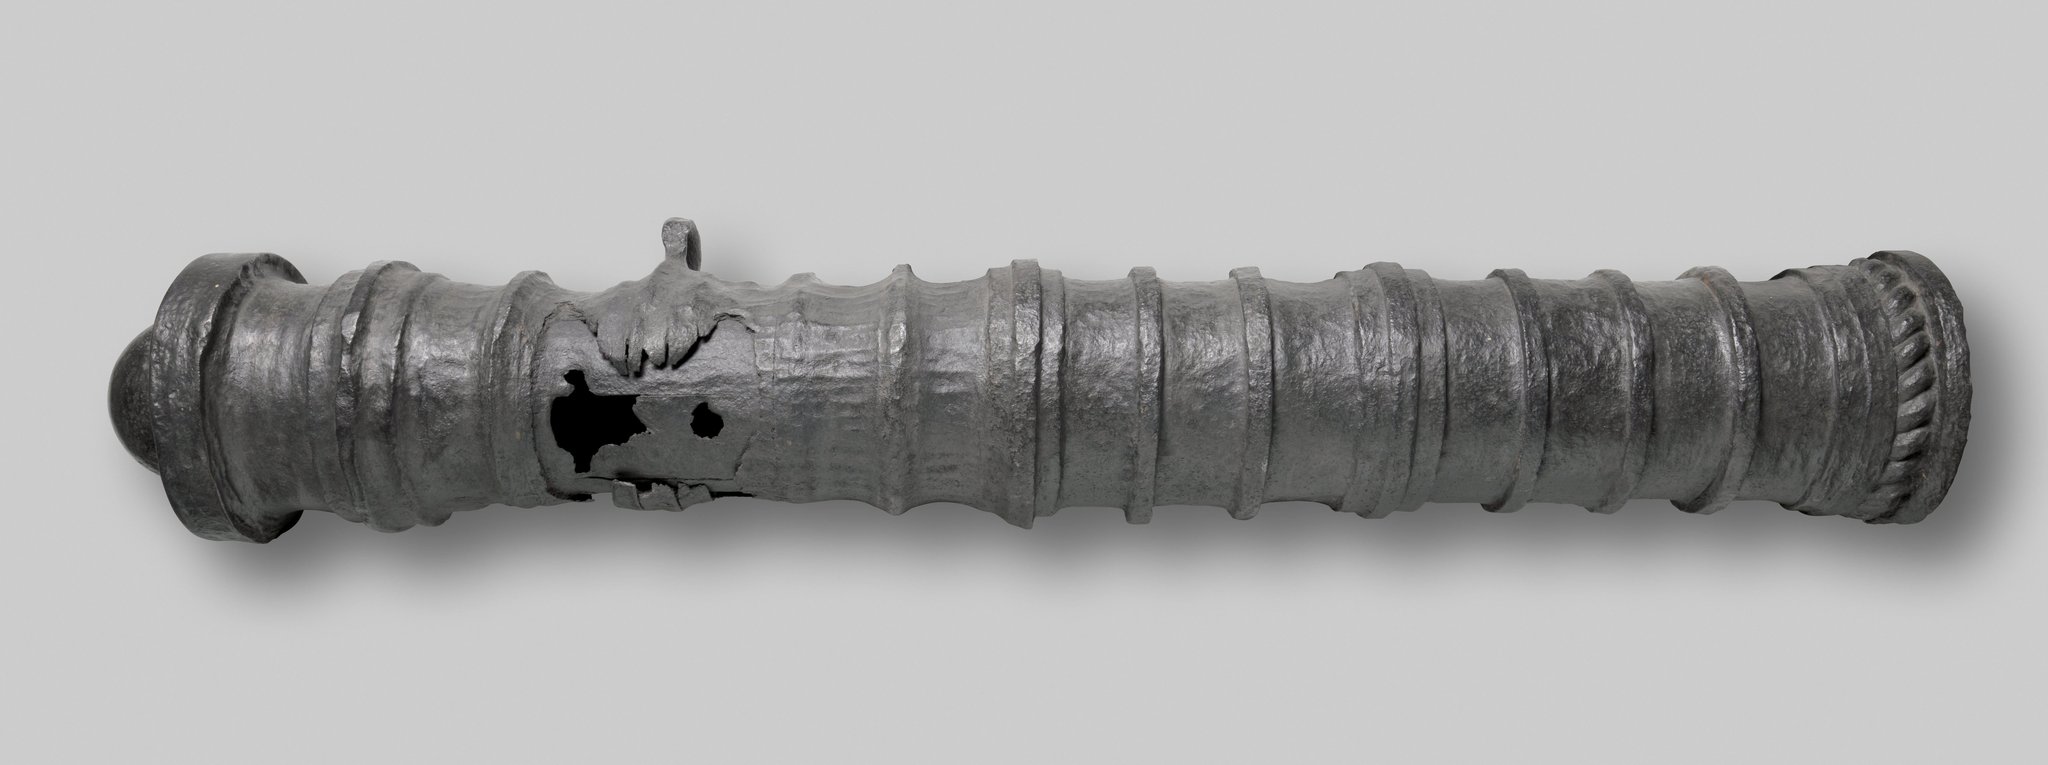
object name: cannon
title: Veldslang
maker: Anonymous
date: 1400-1500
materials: iron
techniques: forging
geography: netherlands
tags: dordrecht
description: Smeedijzeren kanon bestaande uit een aantal staven in buisvorm tegen elkaar gelegd en in het vuur aaneengesmeed. Ter versteviging zijn ijzeren ringen aangebracht. Op de buitenkant van de voorste ring een eenvoudige kabelversiering. Aan de voorzijde van deze ring zijn putten geslagen. Aangesmede ijzeren lus. Aan de achterzijde is een kogel ingeslagen. Gemerkt.